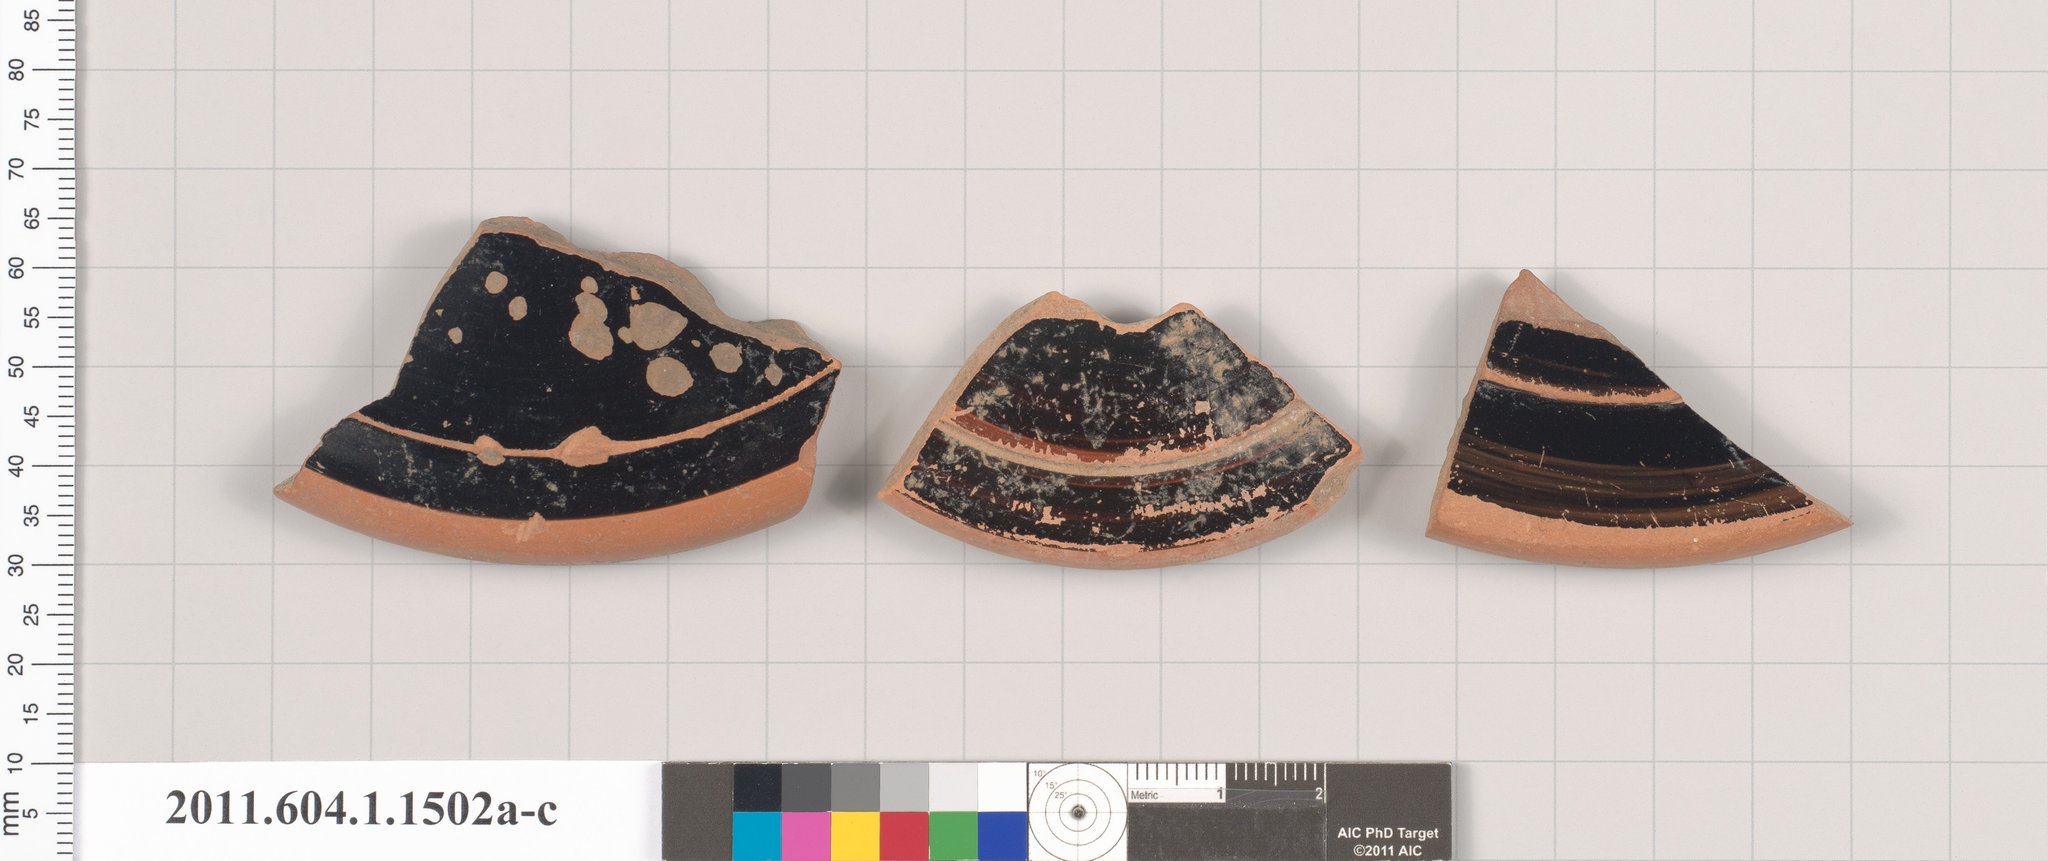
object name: kylix fragment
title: Terracotta fragments of kylikes (drinking cups)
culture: greek, attic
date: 500-401 BCE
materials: terracotta